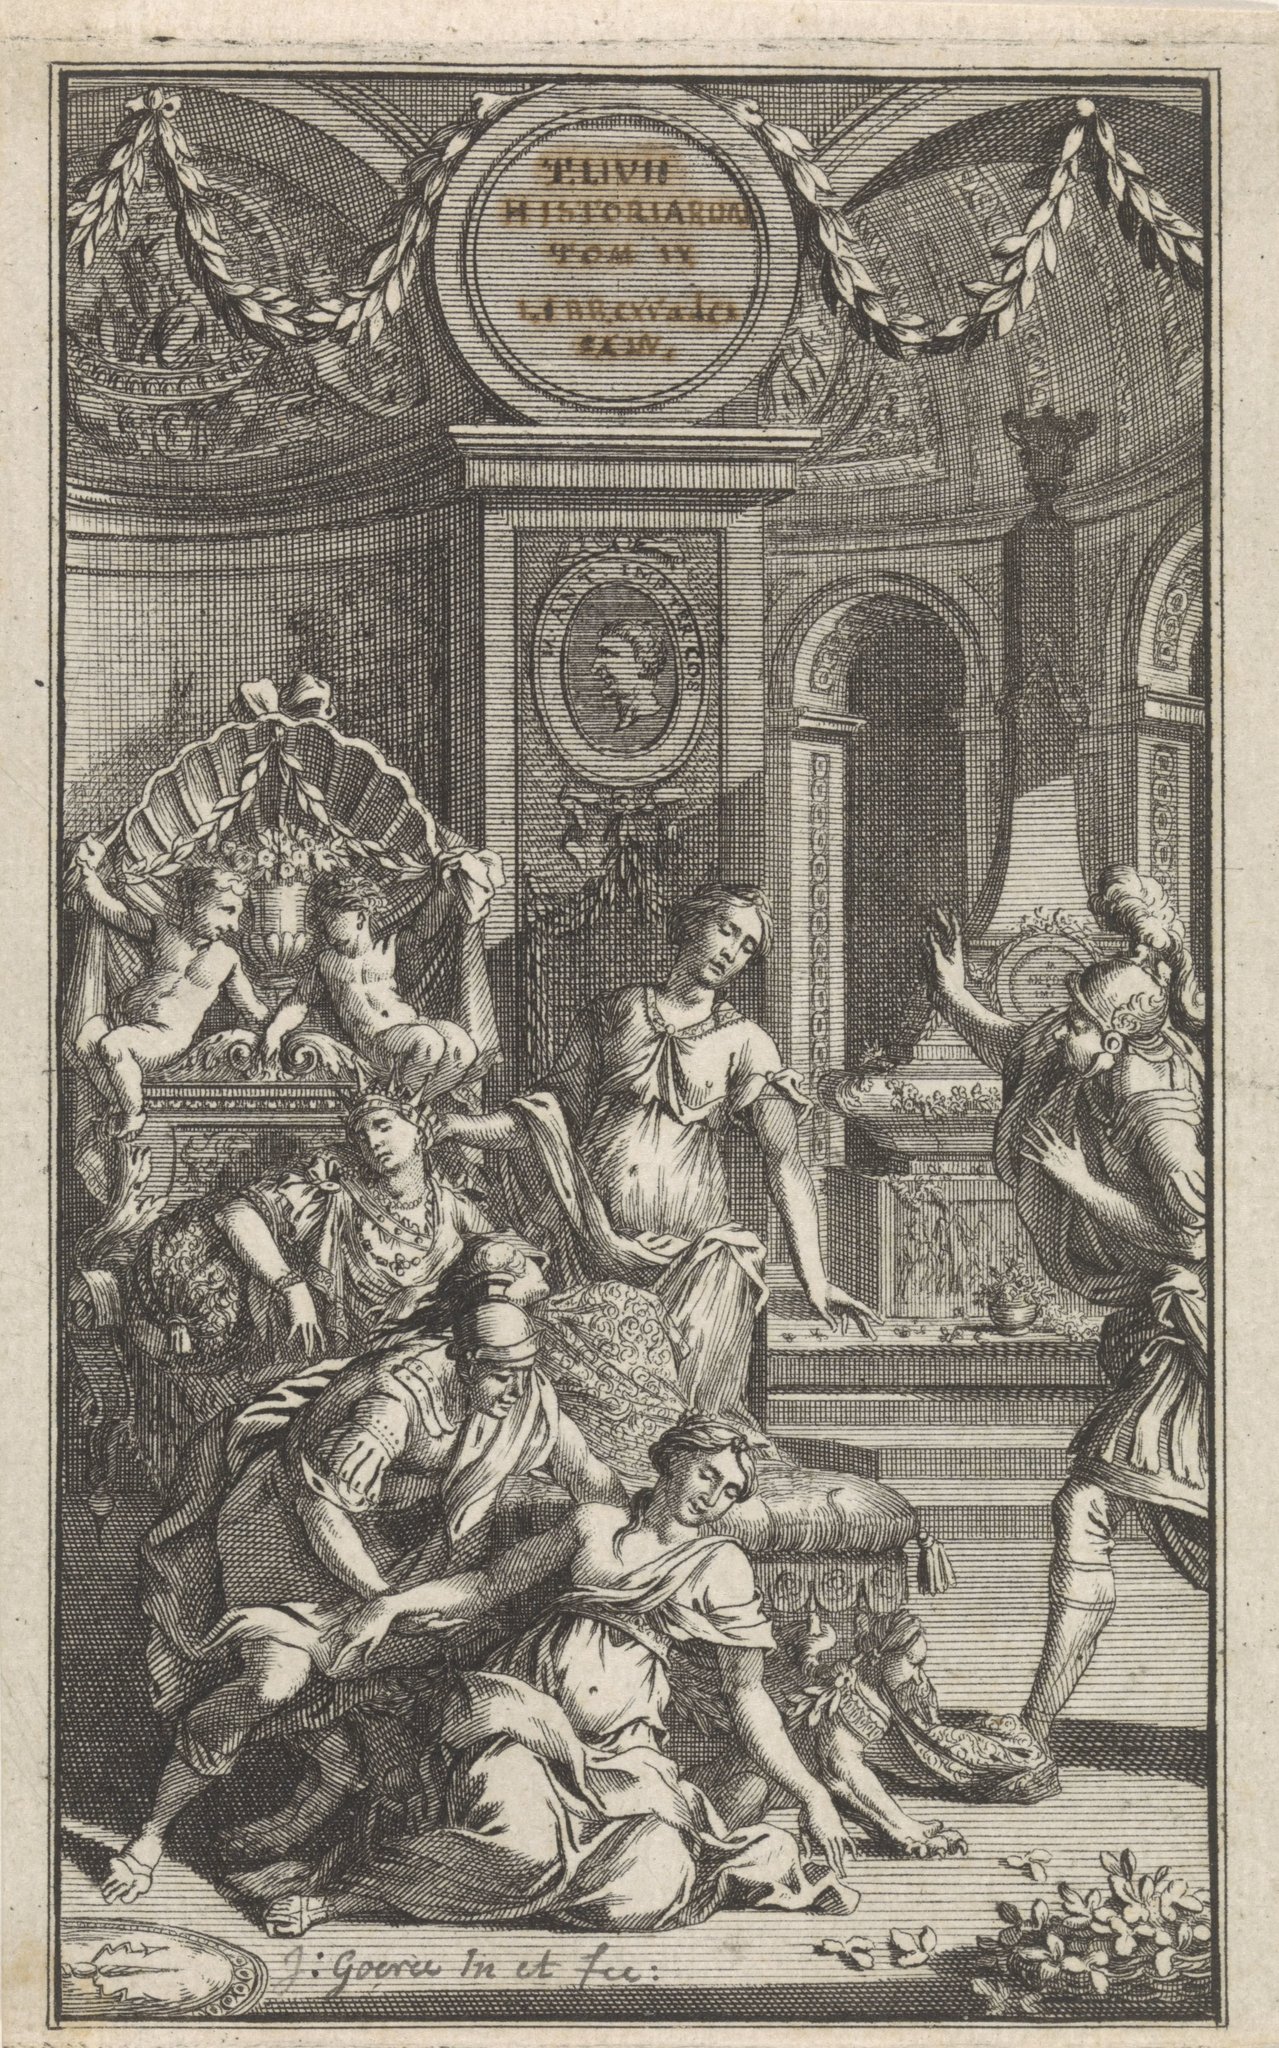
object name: print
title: Zelfmoord van Cleopatra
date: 1710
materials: paper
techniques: brush, engraving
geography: amsterdam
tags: death of cleopatra: she commits suicide by holding to her breast an asp, which she has taken from a basket of figs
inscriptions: collector's mark: Lugt 240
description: Een Romeins interieur. Cleopatra ligt dood op een ornamenteel ligbed. Haar dienstmaagden en twee soldaten ontdekken de zelfmoord. Bovenaan de prent in een medaillon de titel van het boekwerk.